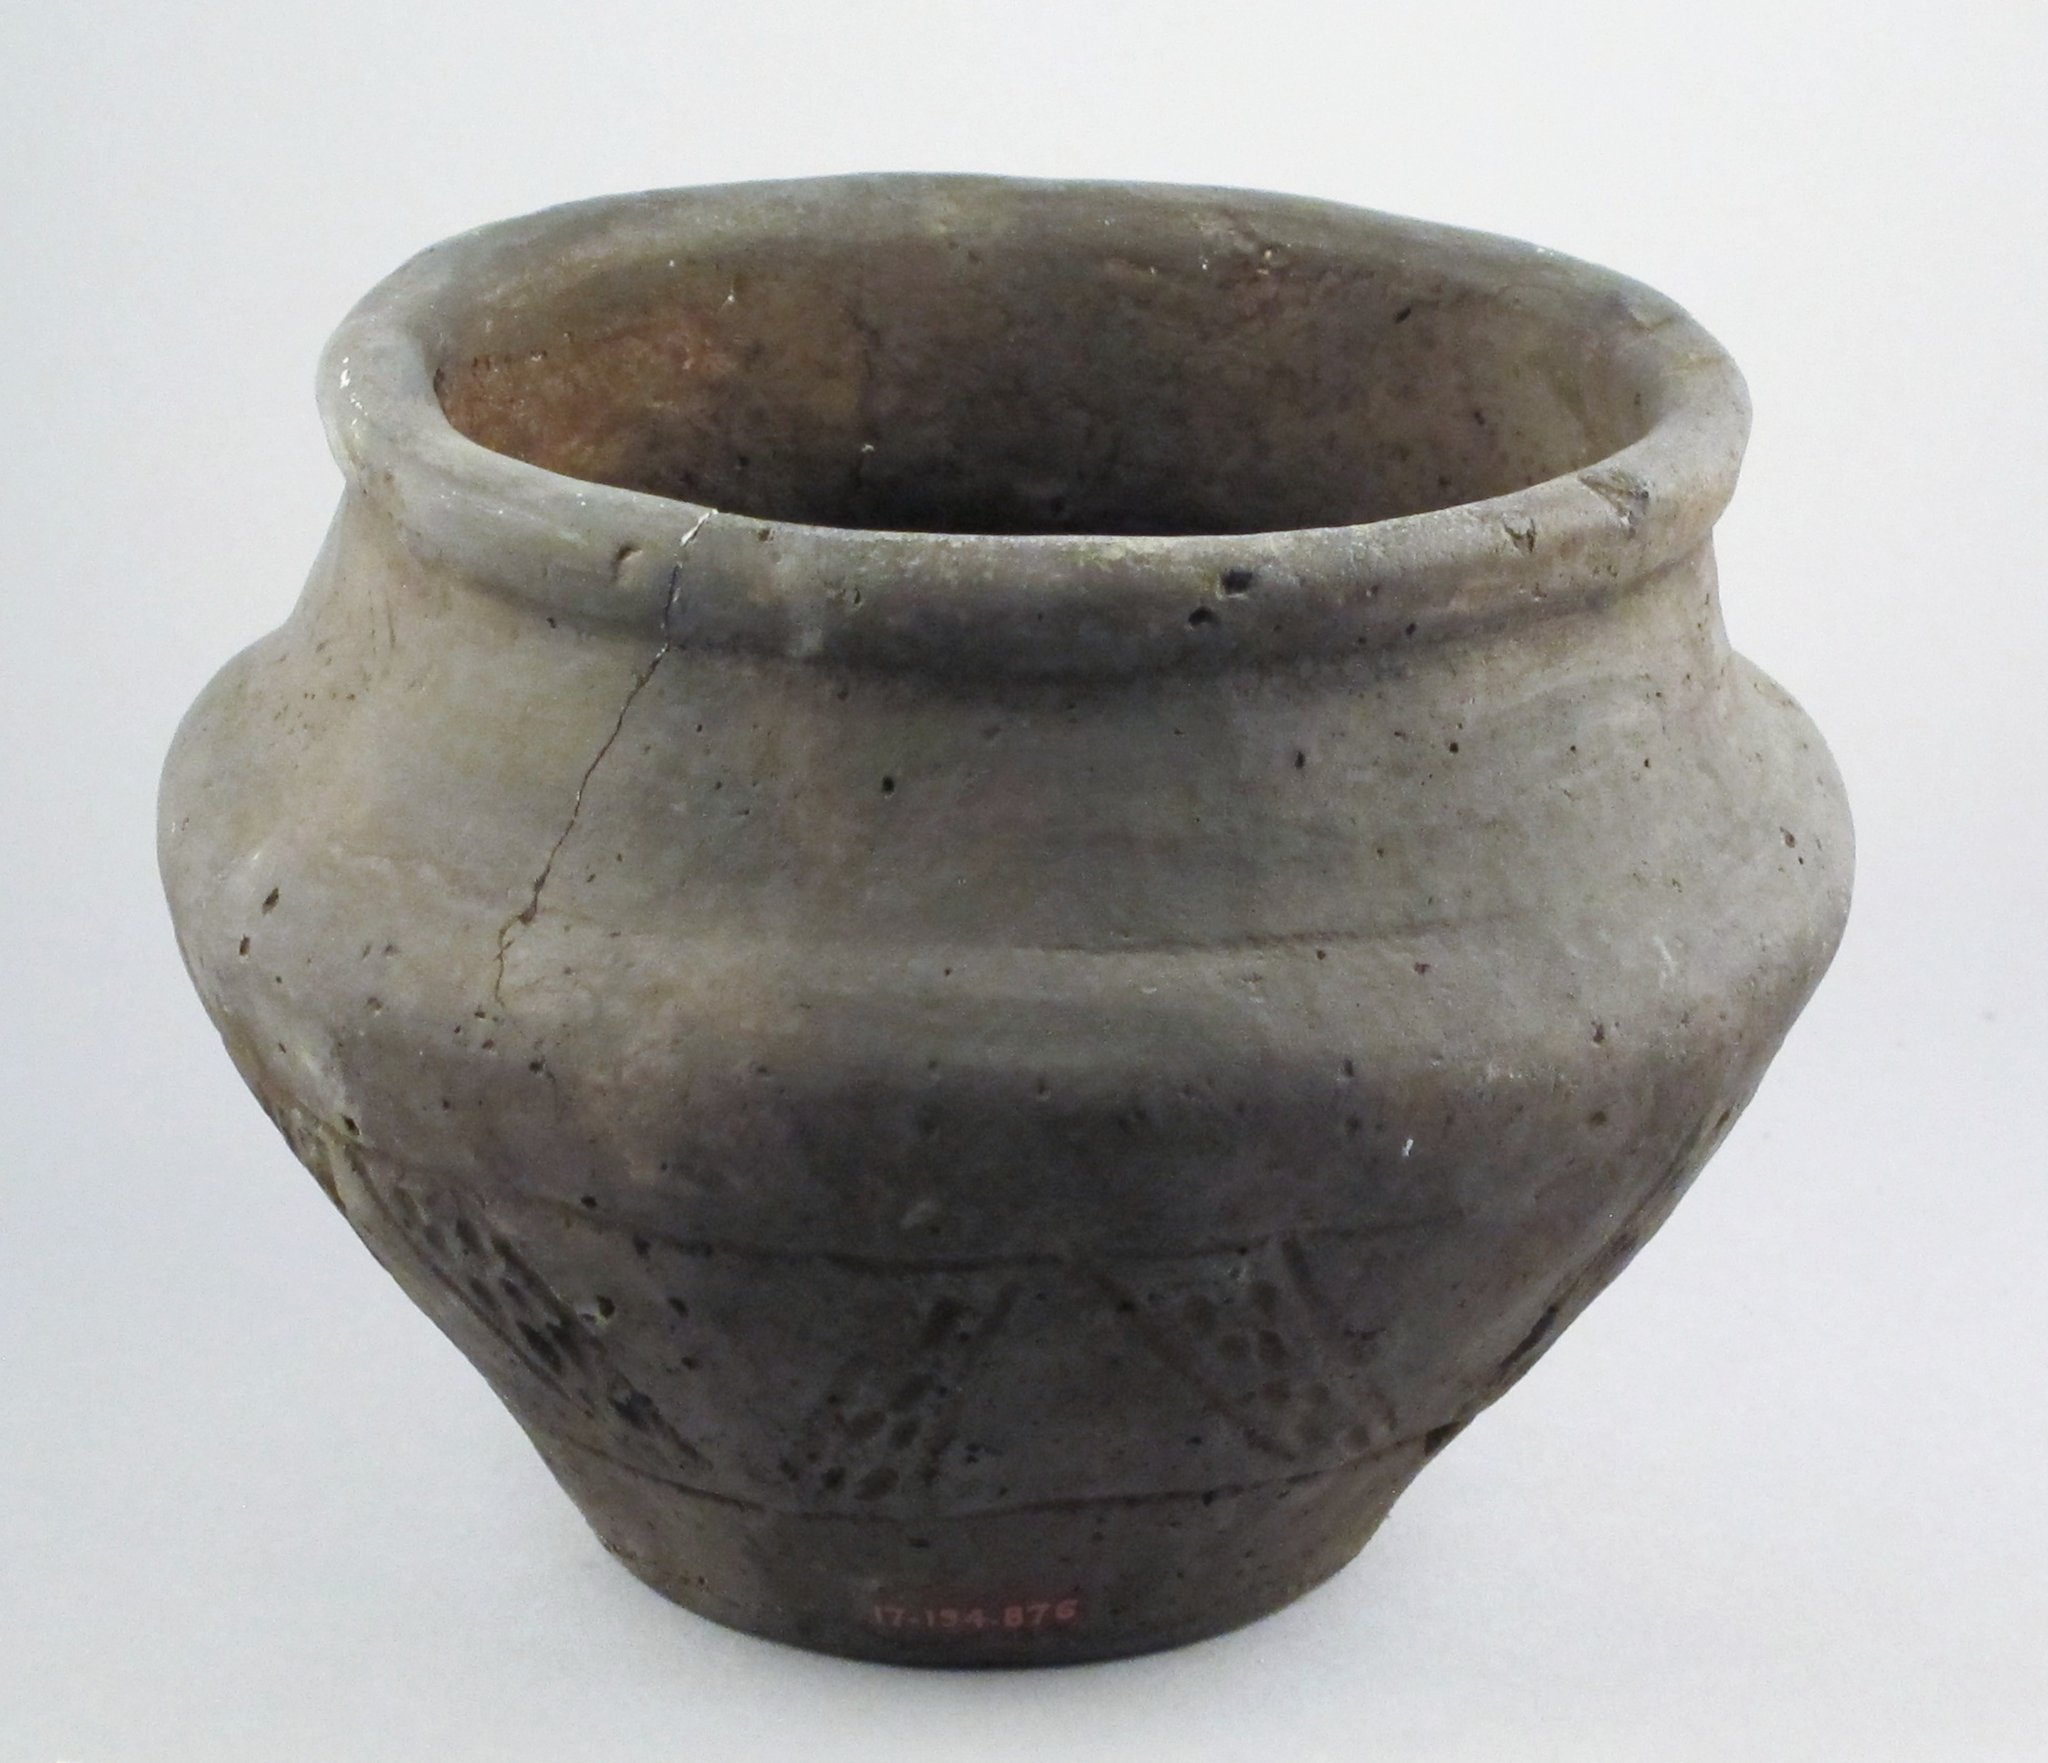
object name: bowl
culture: roman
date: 670 BCE-330 CE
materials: terracotta